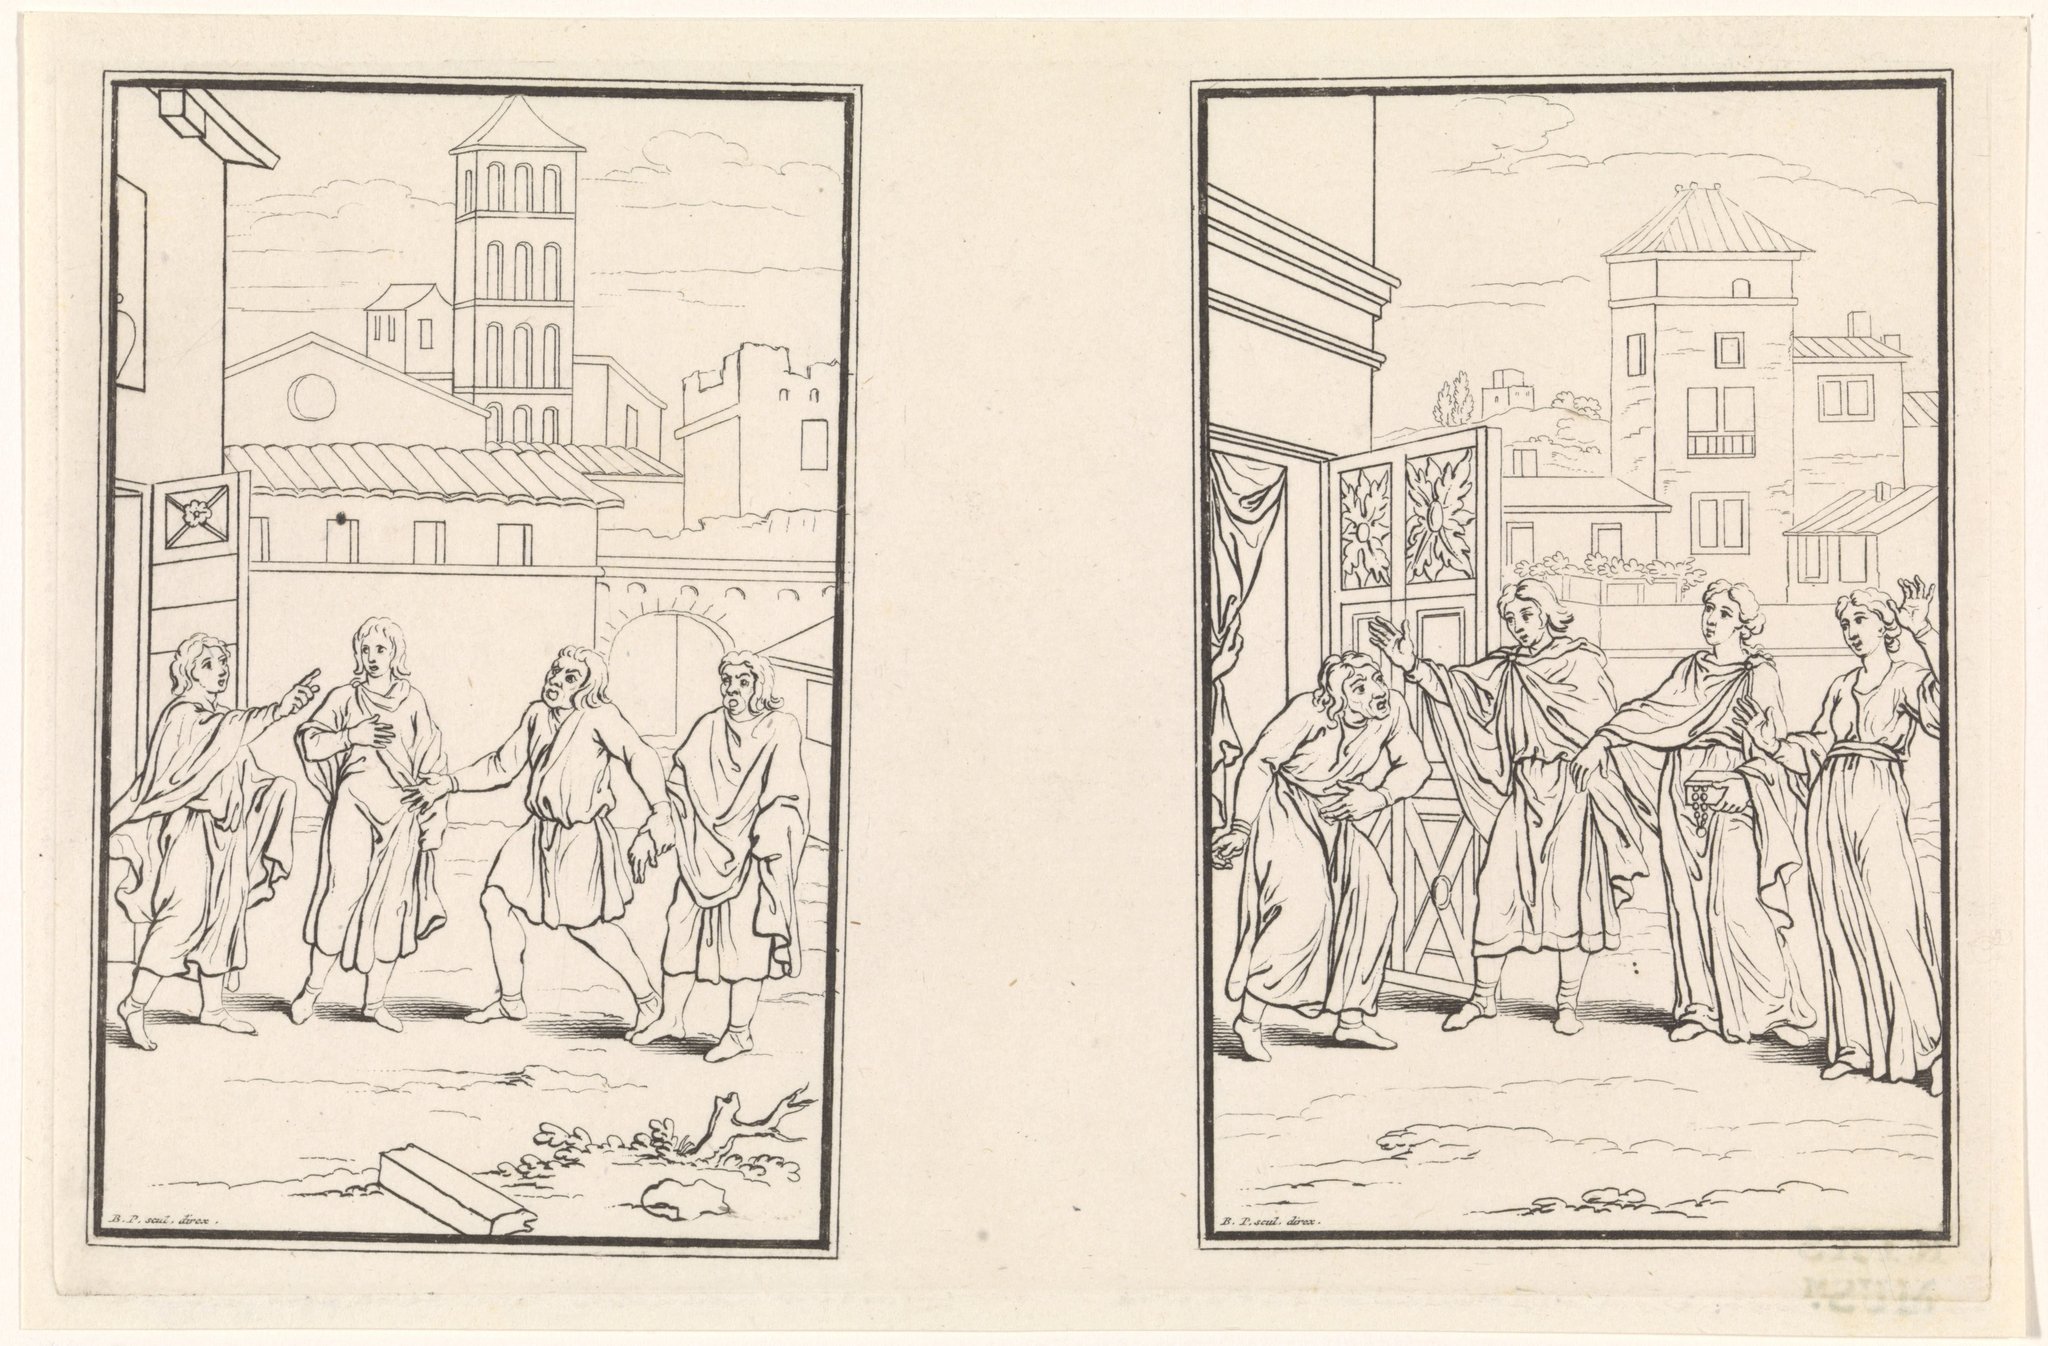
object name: book illustration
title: Twee scènes uit de komedie Adelphoe van Terentius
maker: bernard picart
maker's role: draughtsman, print maker, publisher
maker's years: 1673-1733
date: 1716-1718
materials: paper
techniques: engraving, etching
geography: amsterdam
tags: specific works of literature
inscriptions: collector's mark: Lugt 2165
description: Definitieve staat van deze prenten ook gebruikt als illustratie in: Terentius, Publius. Les comedies de Terence: avec la traduction et les remarques, deel II, na p. 312 en na p. 408. [Geannoteerd door] Anne Dacier. Rotterdam: Caspar Fritsch, 1717.